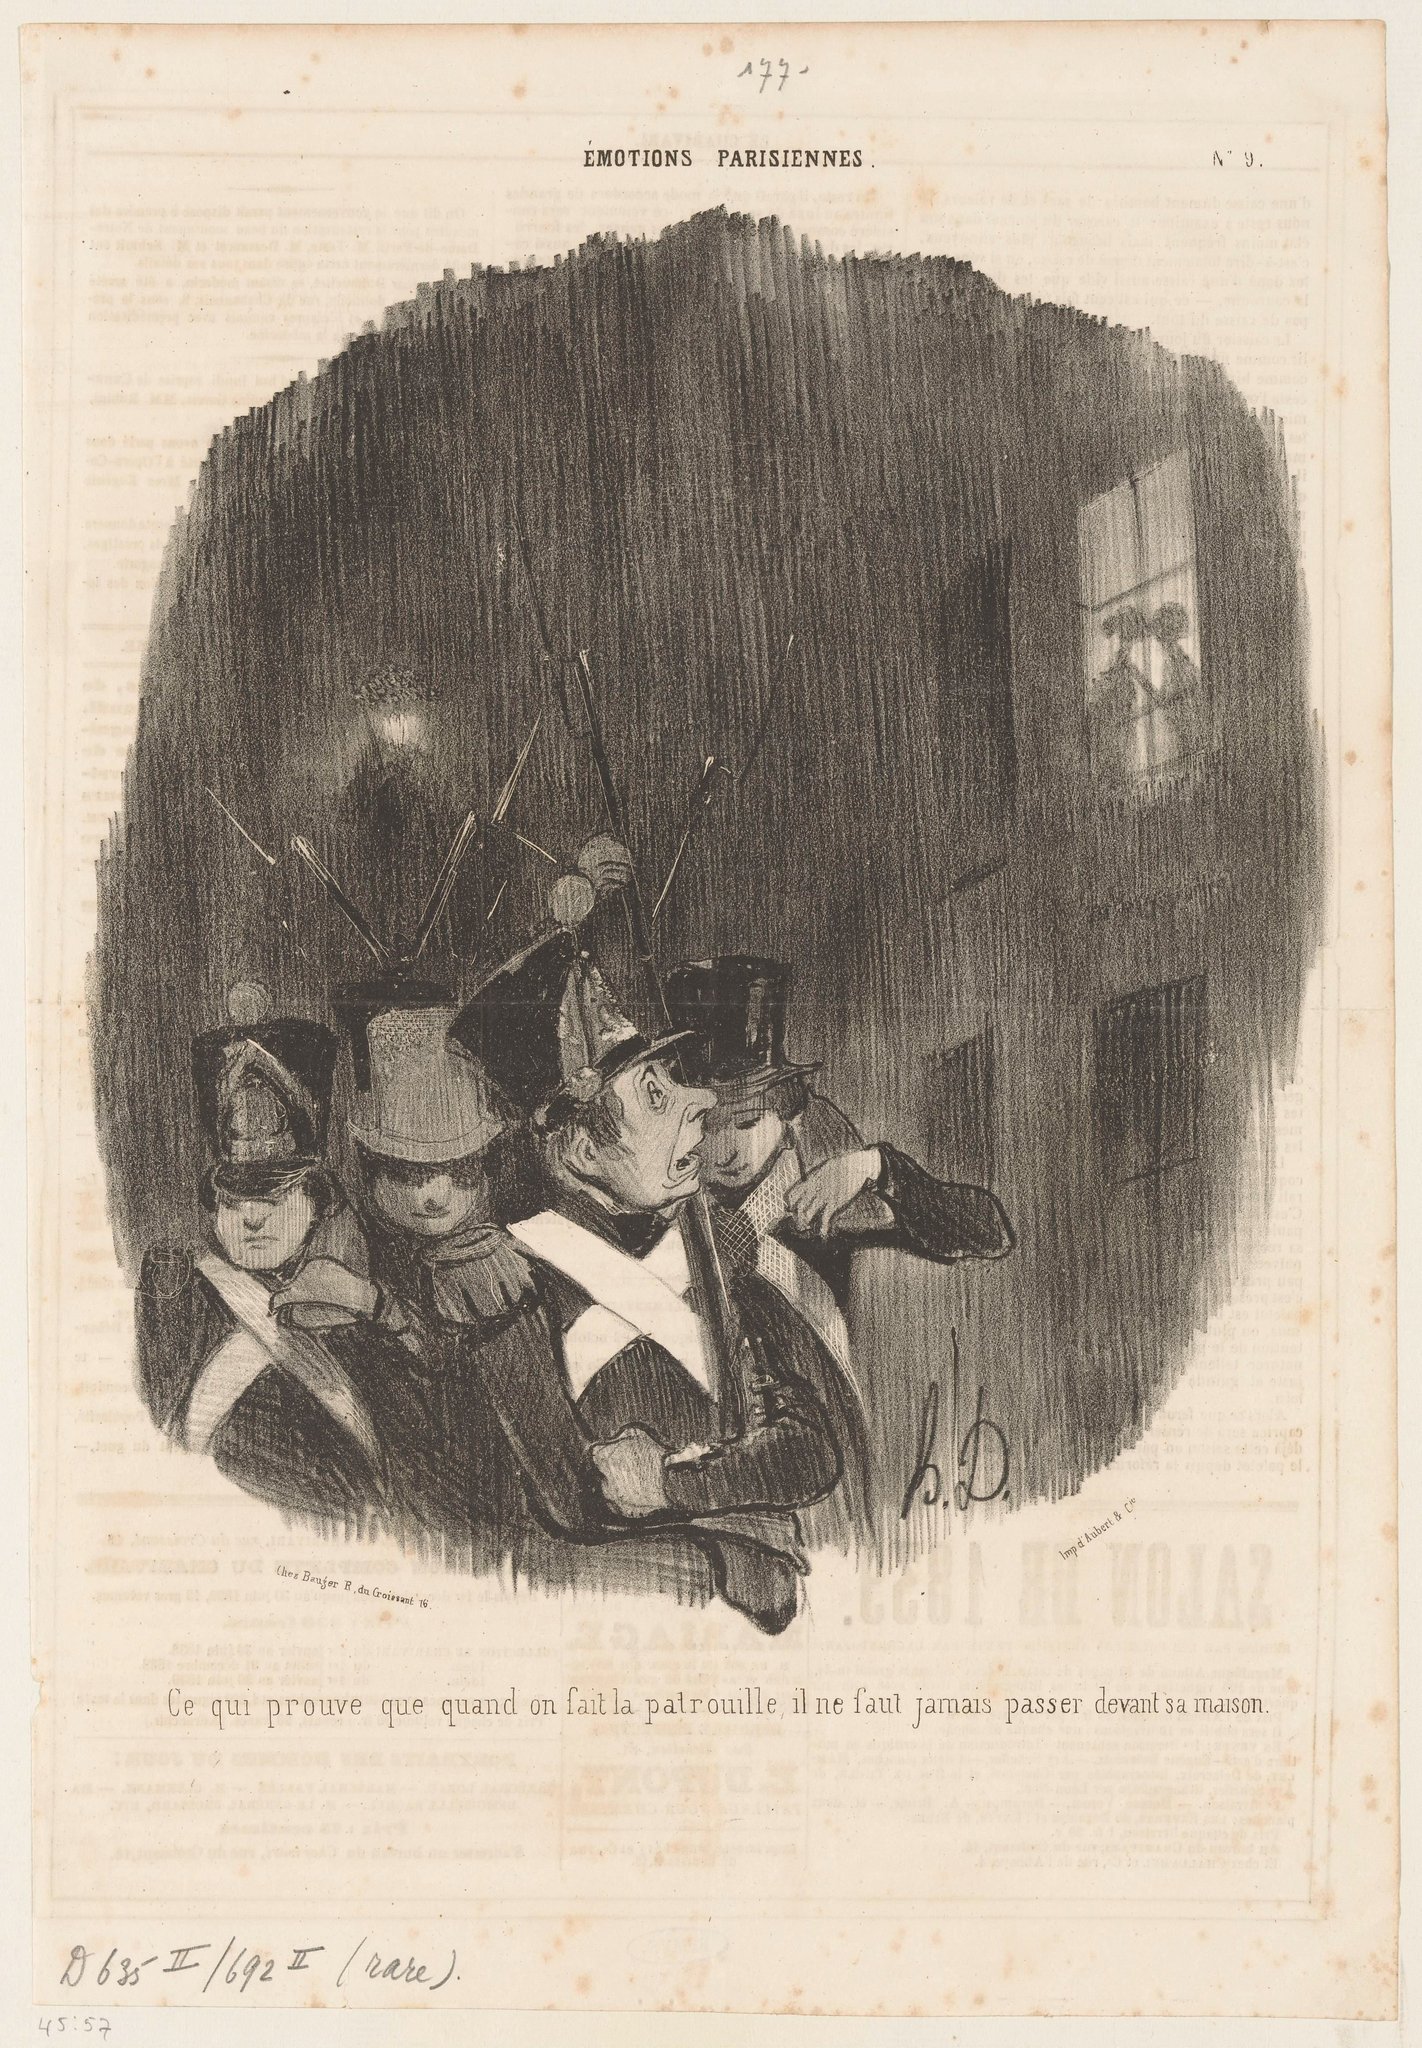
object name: cartoon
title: Émotions Parisiennes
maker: honoré daumier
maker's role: draughtsman, painter, print maker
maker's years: 1808-1879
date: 1839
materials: paper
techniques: letterpress printing, lithograph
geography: paris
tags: night patrol, caricatures (human types), adultery, paris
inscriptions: collector's mark: Lugt 2228a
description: Prent mogelijk uit: Le Charivari, 24 oktober 1839.